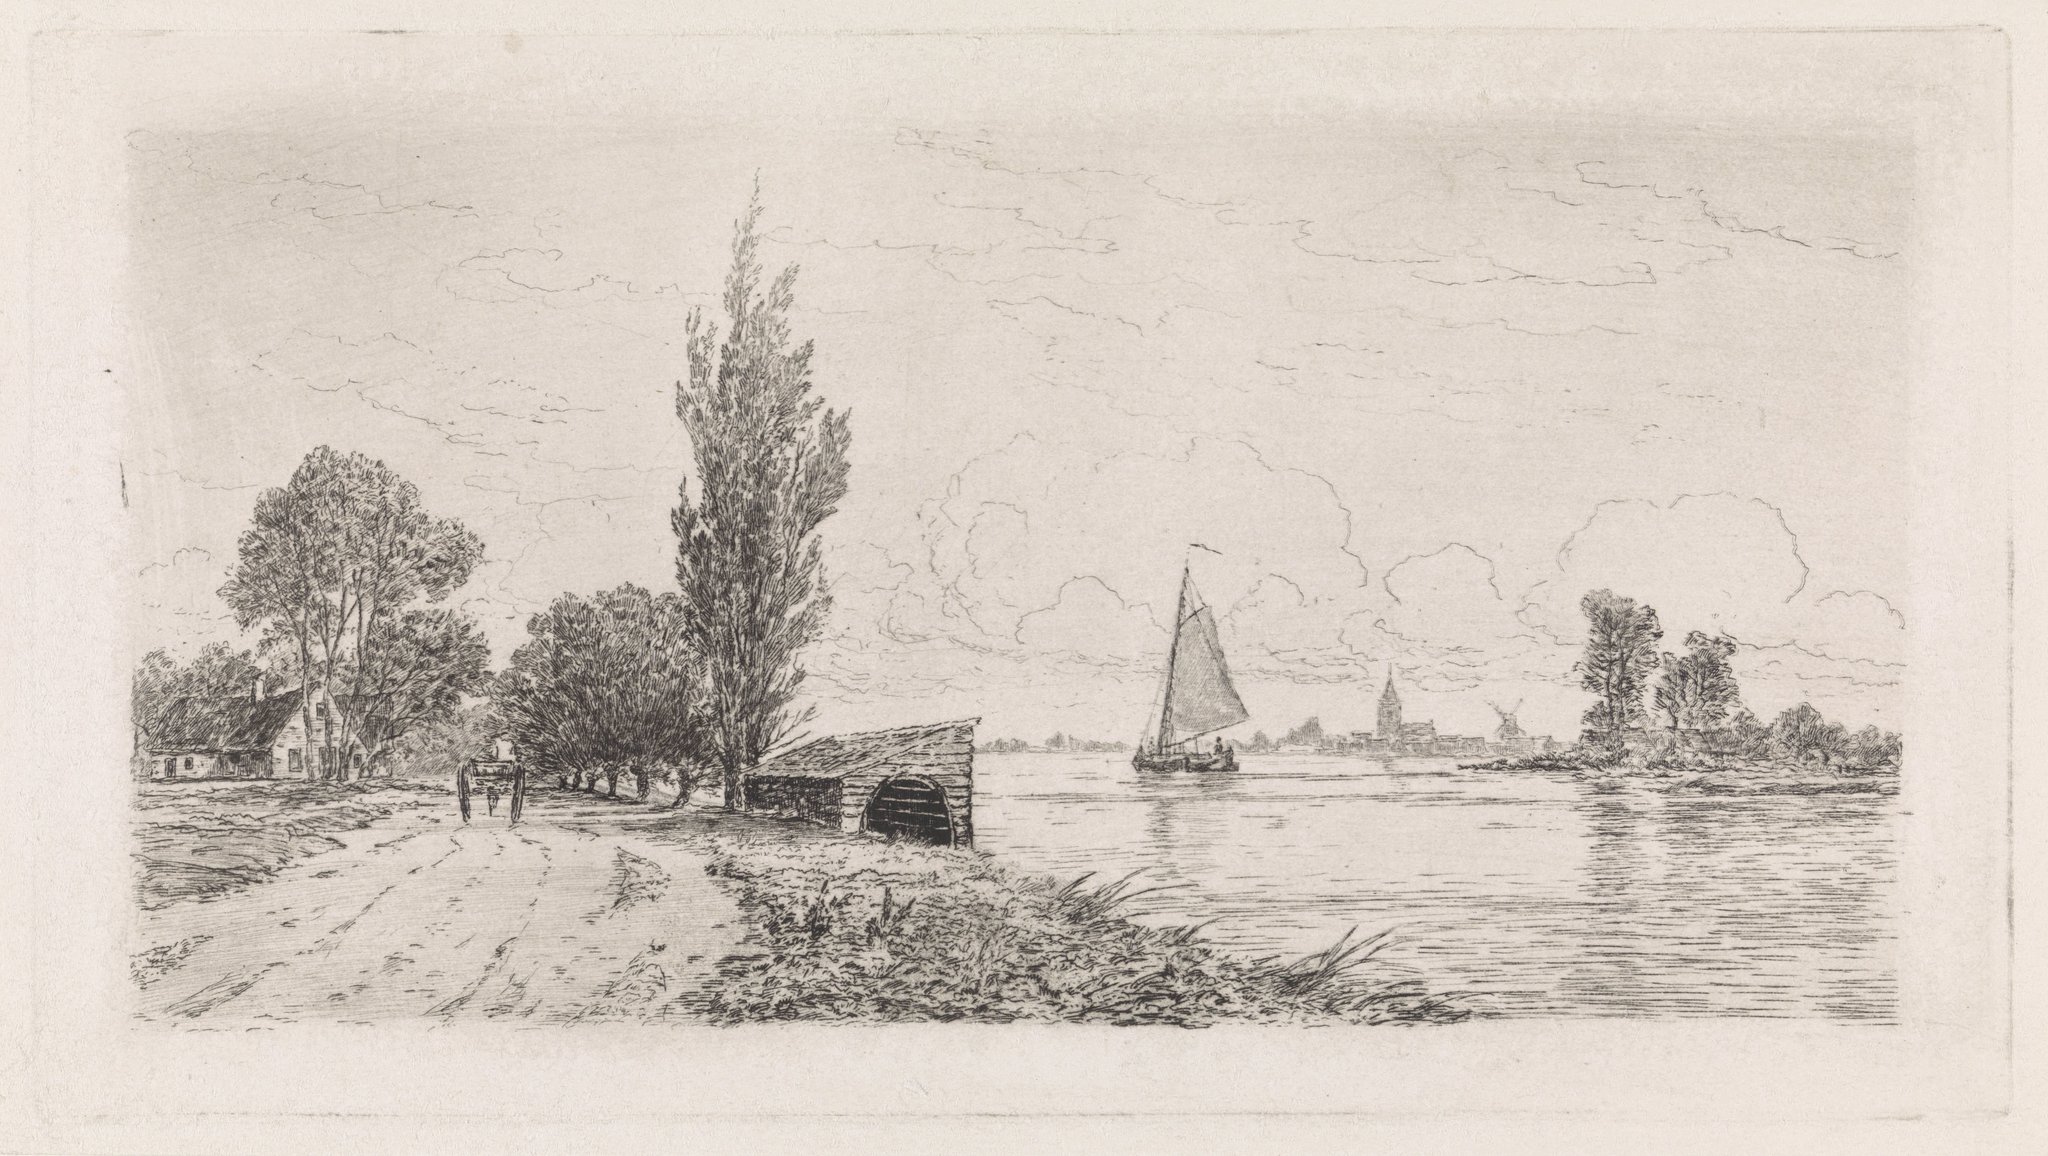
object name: print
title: Rivierlandschap met zeilschip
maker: elias stark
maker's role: draughtsman, print maker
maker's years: 1849-1933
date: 1889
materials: paper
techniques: aquatint, etching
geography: nieuwer-amstel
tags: sailing-ship, sailing-boat, river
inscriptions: collector's mark: Lugt 2228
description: Landschap met op de rivier een zeilschip en op de achtergrond een dorp. Links langs het water een weg waarop een wagen rijdt.